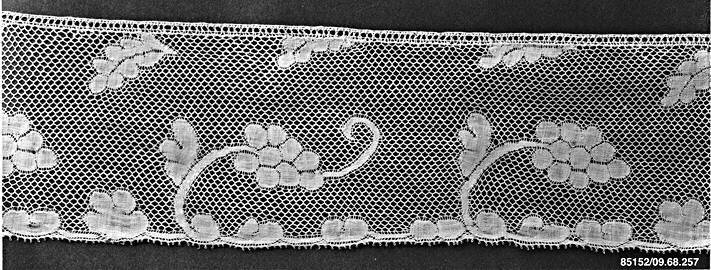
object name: border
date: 1767-1800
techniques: lace